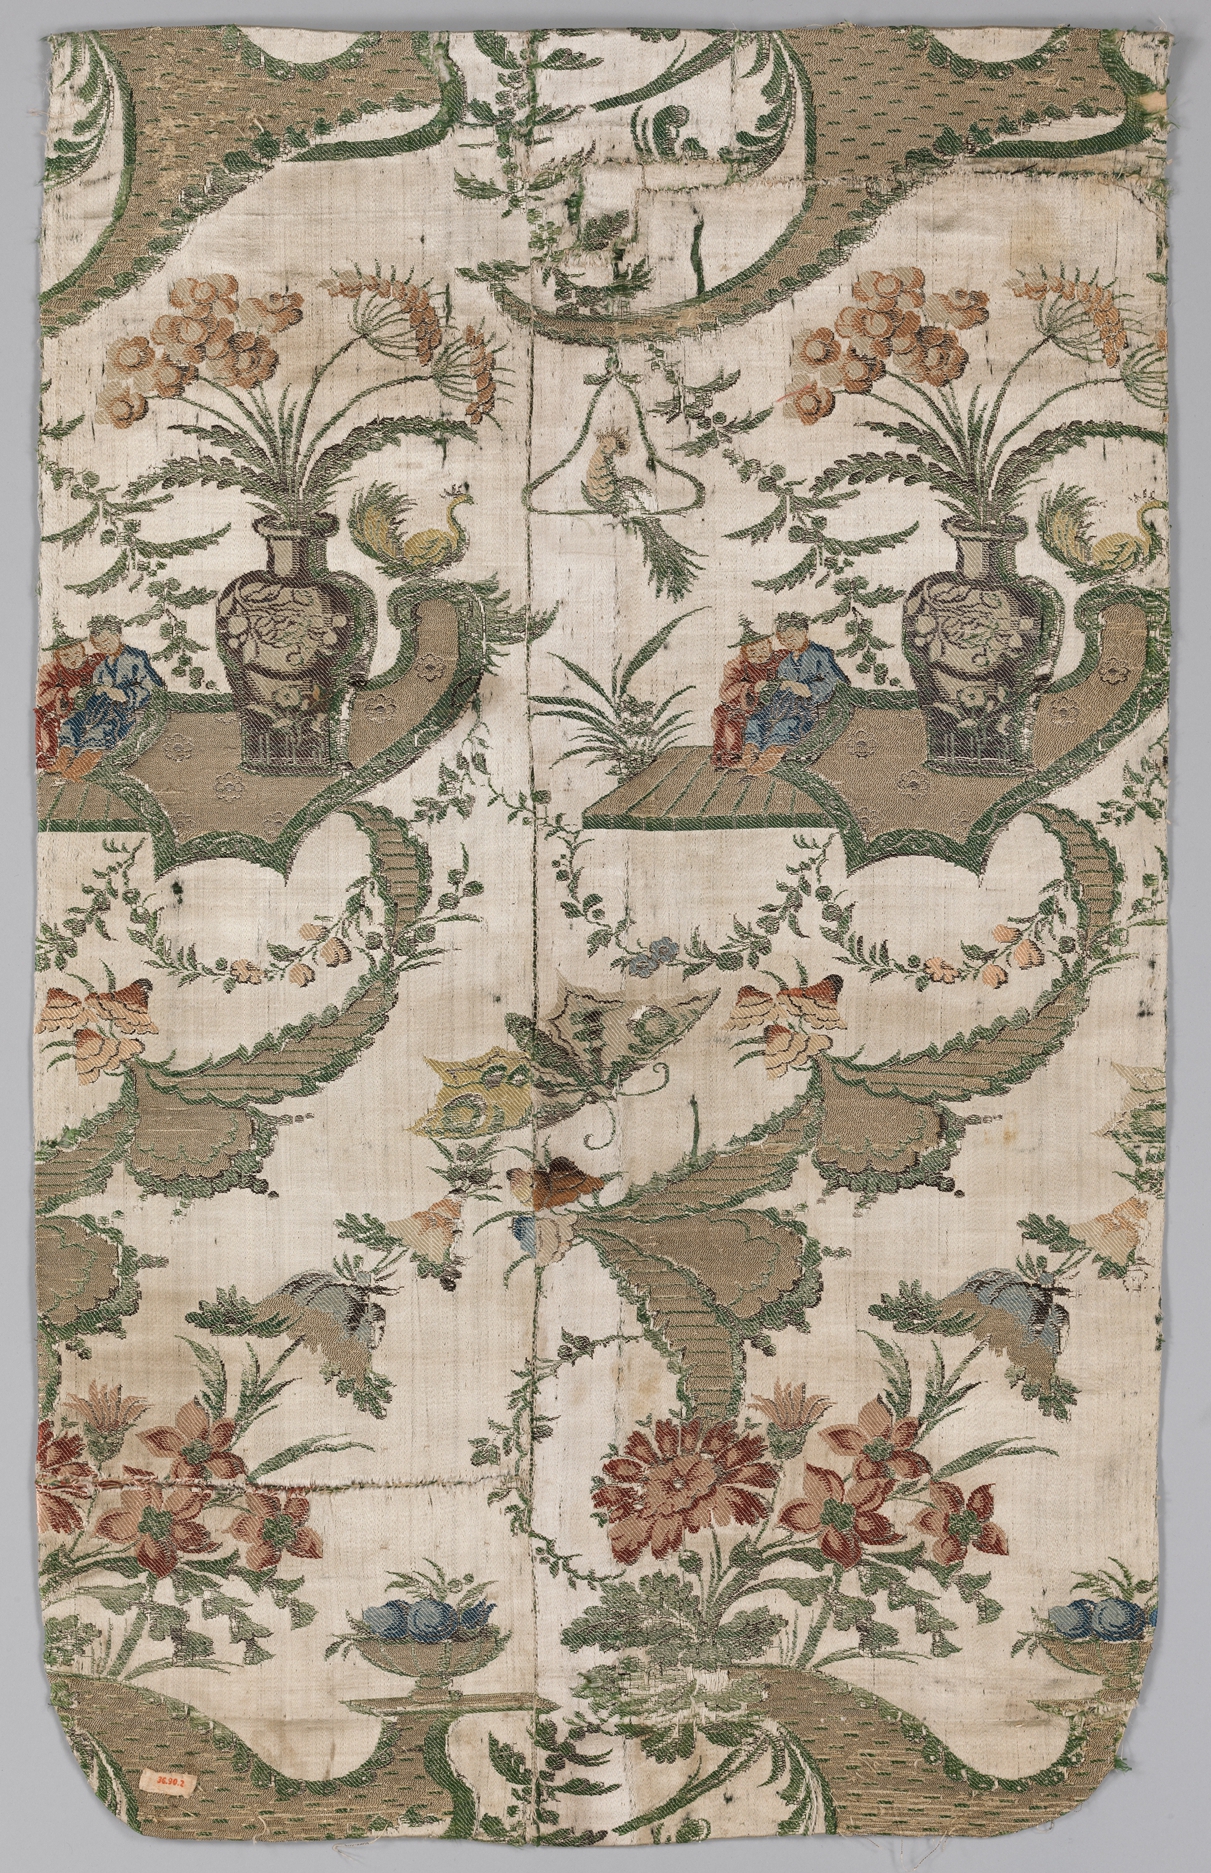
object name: piece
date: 1750-1760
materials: metal thread, silk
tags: human figures,flowers